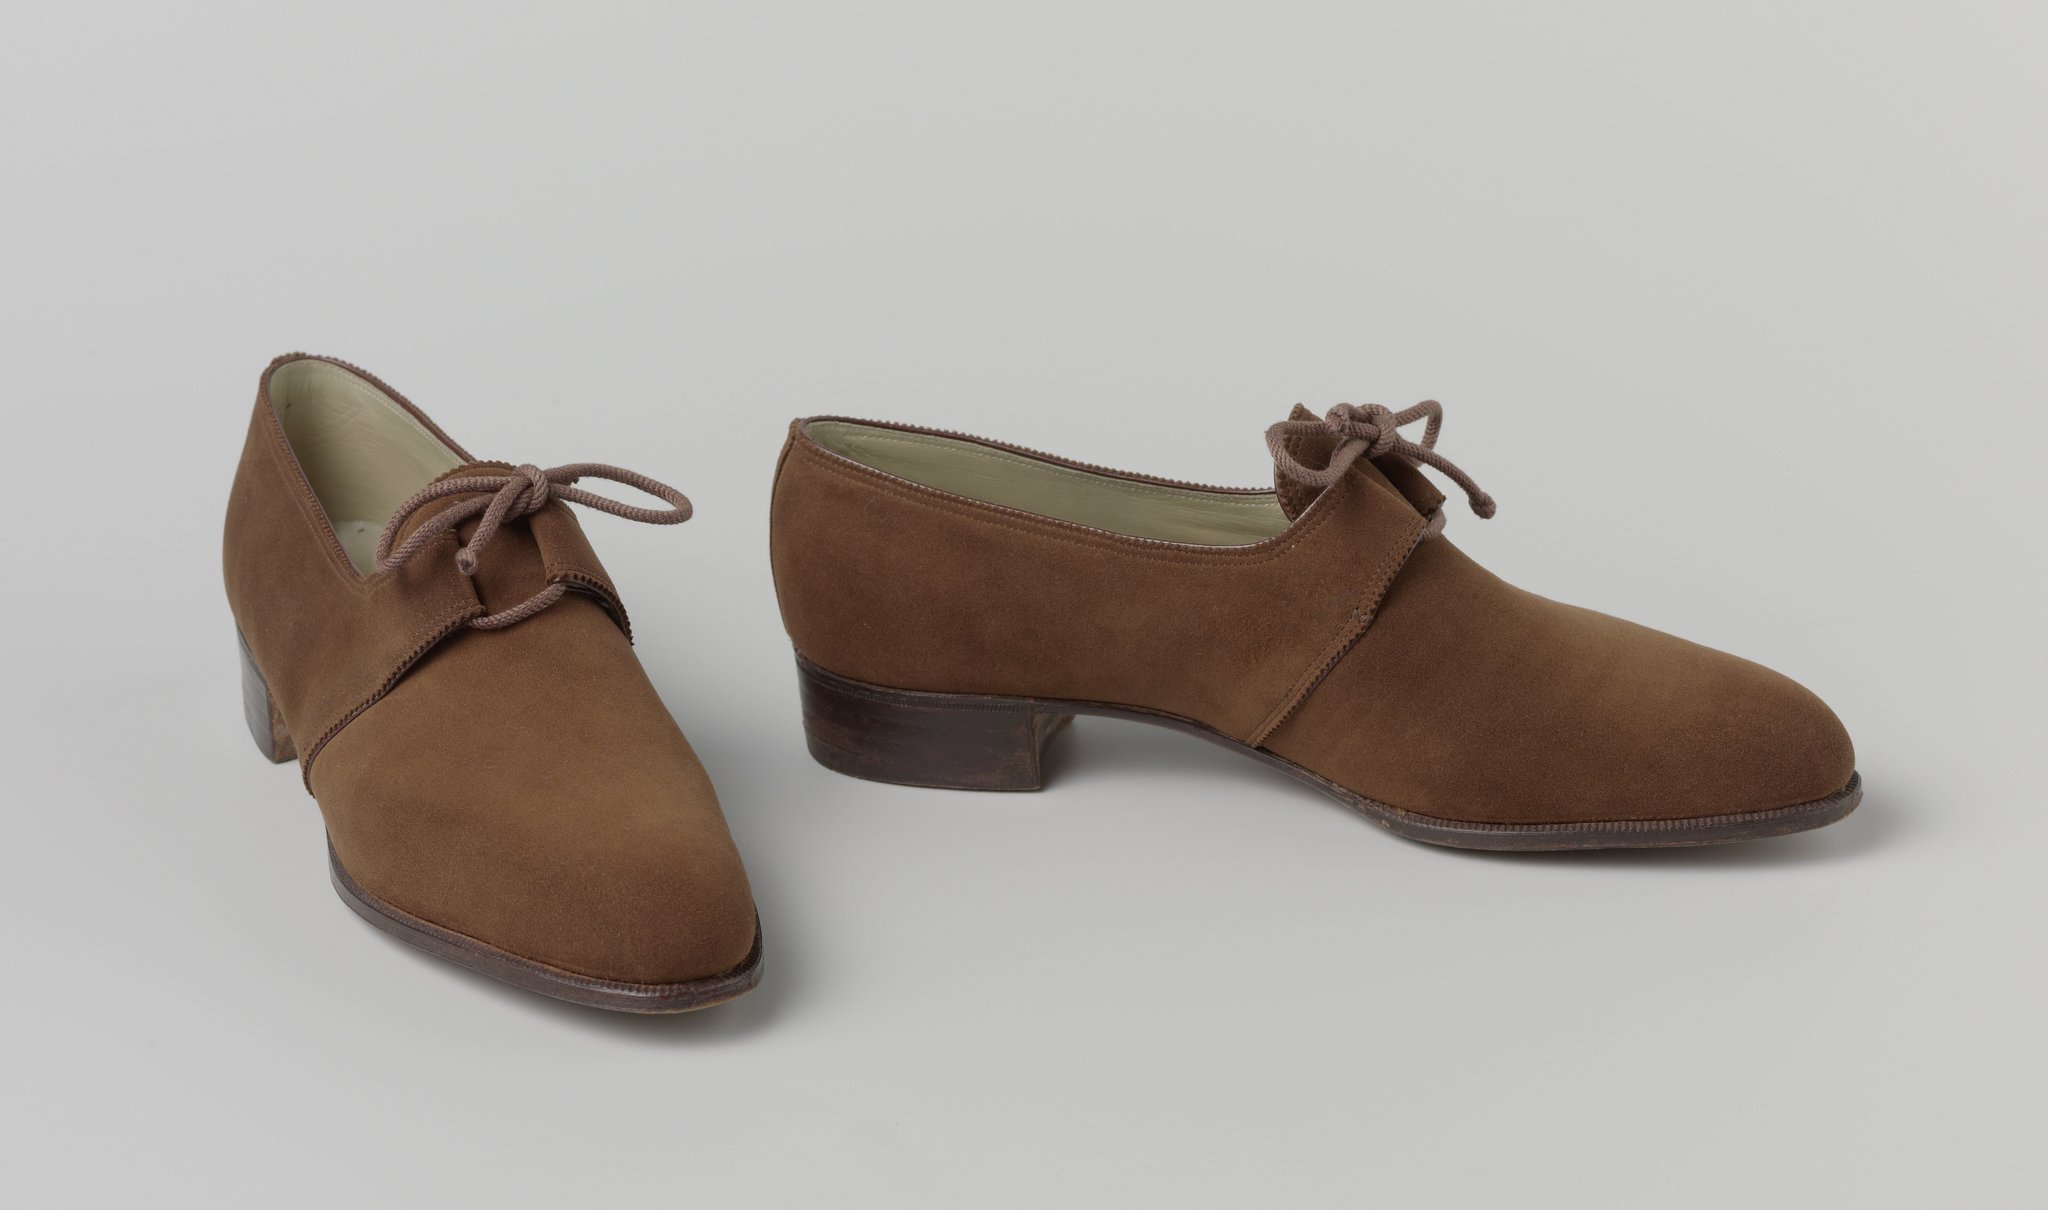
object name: lace up shoe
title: Veterschoen van roestbruin suède afgebiesd met bruin leer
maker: a. van goethem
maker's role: schoenmaker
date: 1930-1960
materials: cotton, leather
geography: brussels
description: Linkerveterschoen van roestbruin suède afgebiesd met bruin leer. Model: glad voorblad met tong. De zijpanden zijn op de wreef teruggeslagen en vormen ieder een lus, waardoor de dikke katoenen veter is geregen. Platte, leren hak. De achternaad wordt gecamoufleerd door een smal bandje suède. Geheel gevoerd met glanzend beige leer. Binnenzool met gouden opdruk. Versiering: het suède is langs de instap en de tong gekarteld. Hieronder is een smalle bies van bruin kalfs(?)leer te zien. Adres (op de binnenzool): A.VAN GOETHEM 15. RUE DE NAMUR/PRES LA PLACE ROYALE/BRUXELLES. Opmerking: onder op de tong van de rechterschoen is met ballpoint geschreven 1320/4637.